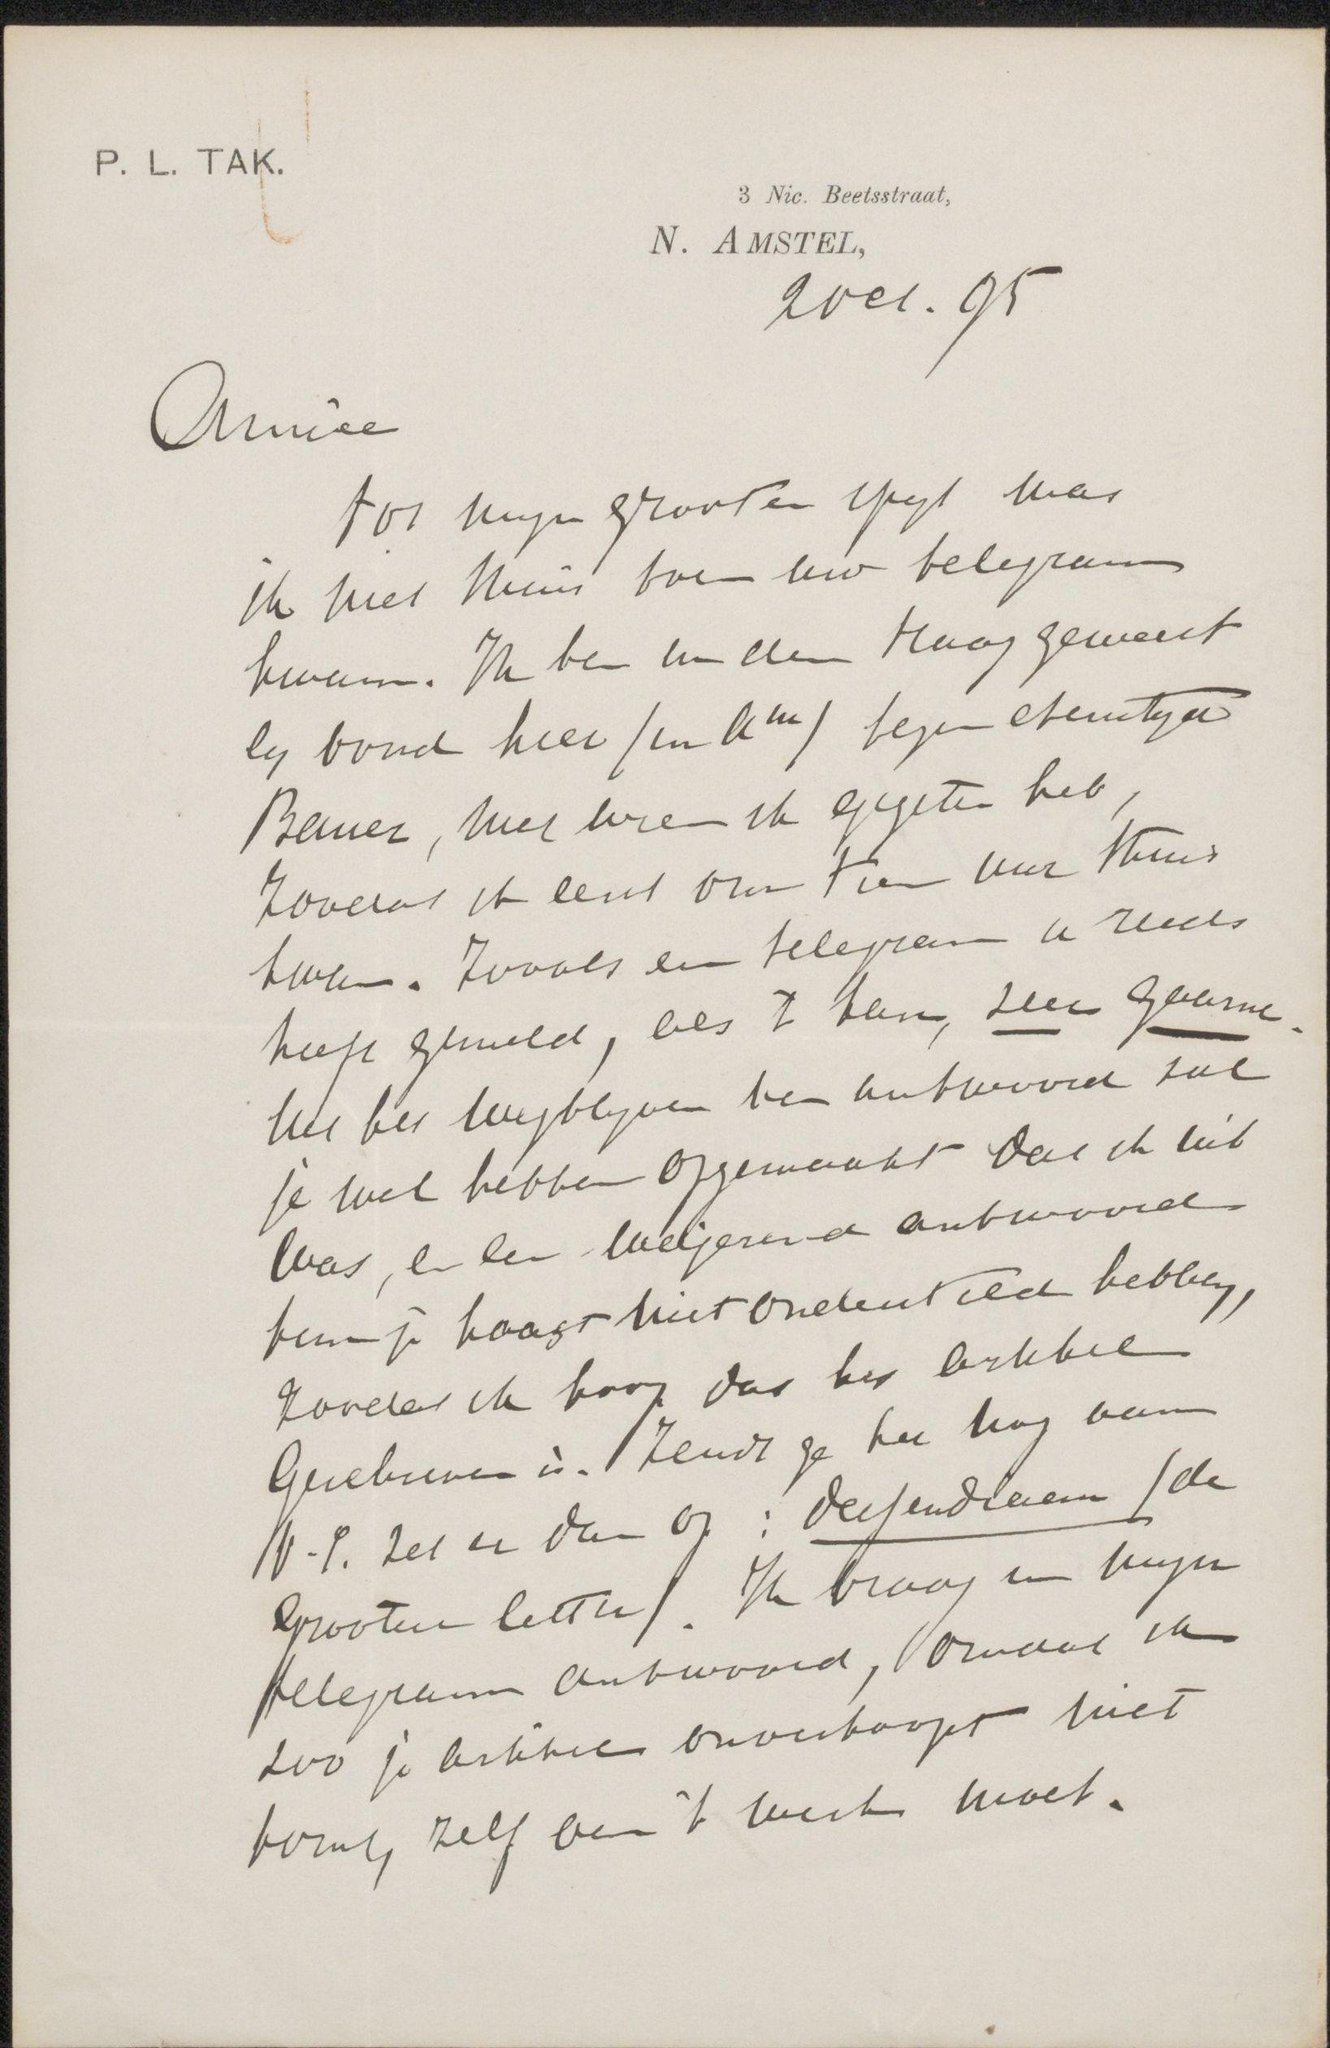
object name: letter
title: Brief aan Jan Veth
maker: pieter lodewijk tak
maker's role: politician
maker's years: 1848-1907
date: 1895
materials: ink, paper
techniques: pen, printing, writing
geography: nieuwer-amstel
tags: dordrecht, painter, designer, jan veth, the hague, print maker, draughtsman, marius bauer, printed matter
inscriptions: watermark, collector's mark: ‘RPK’